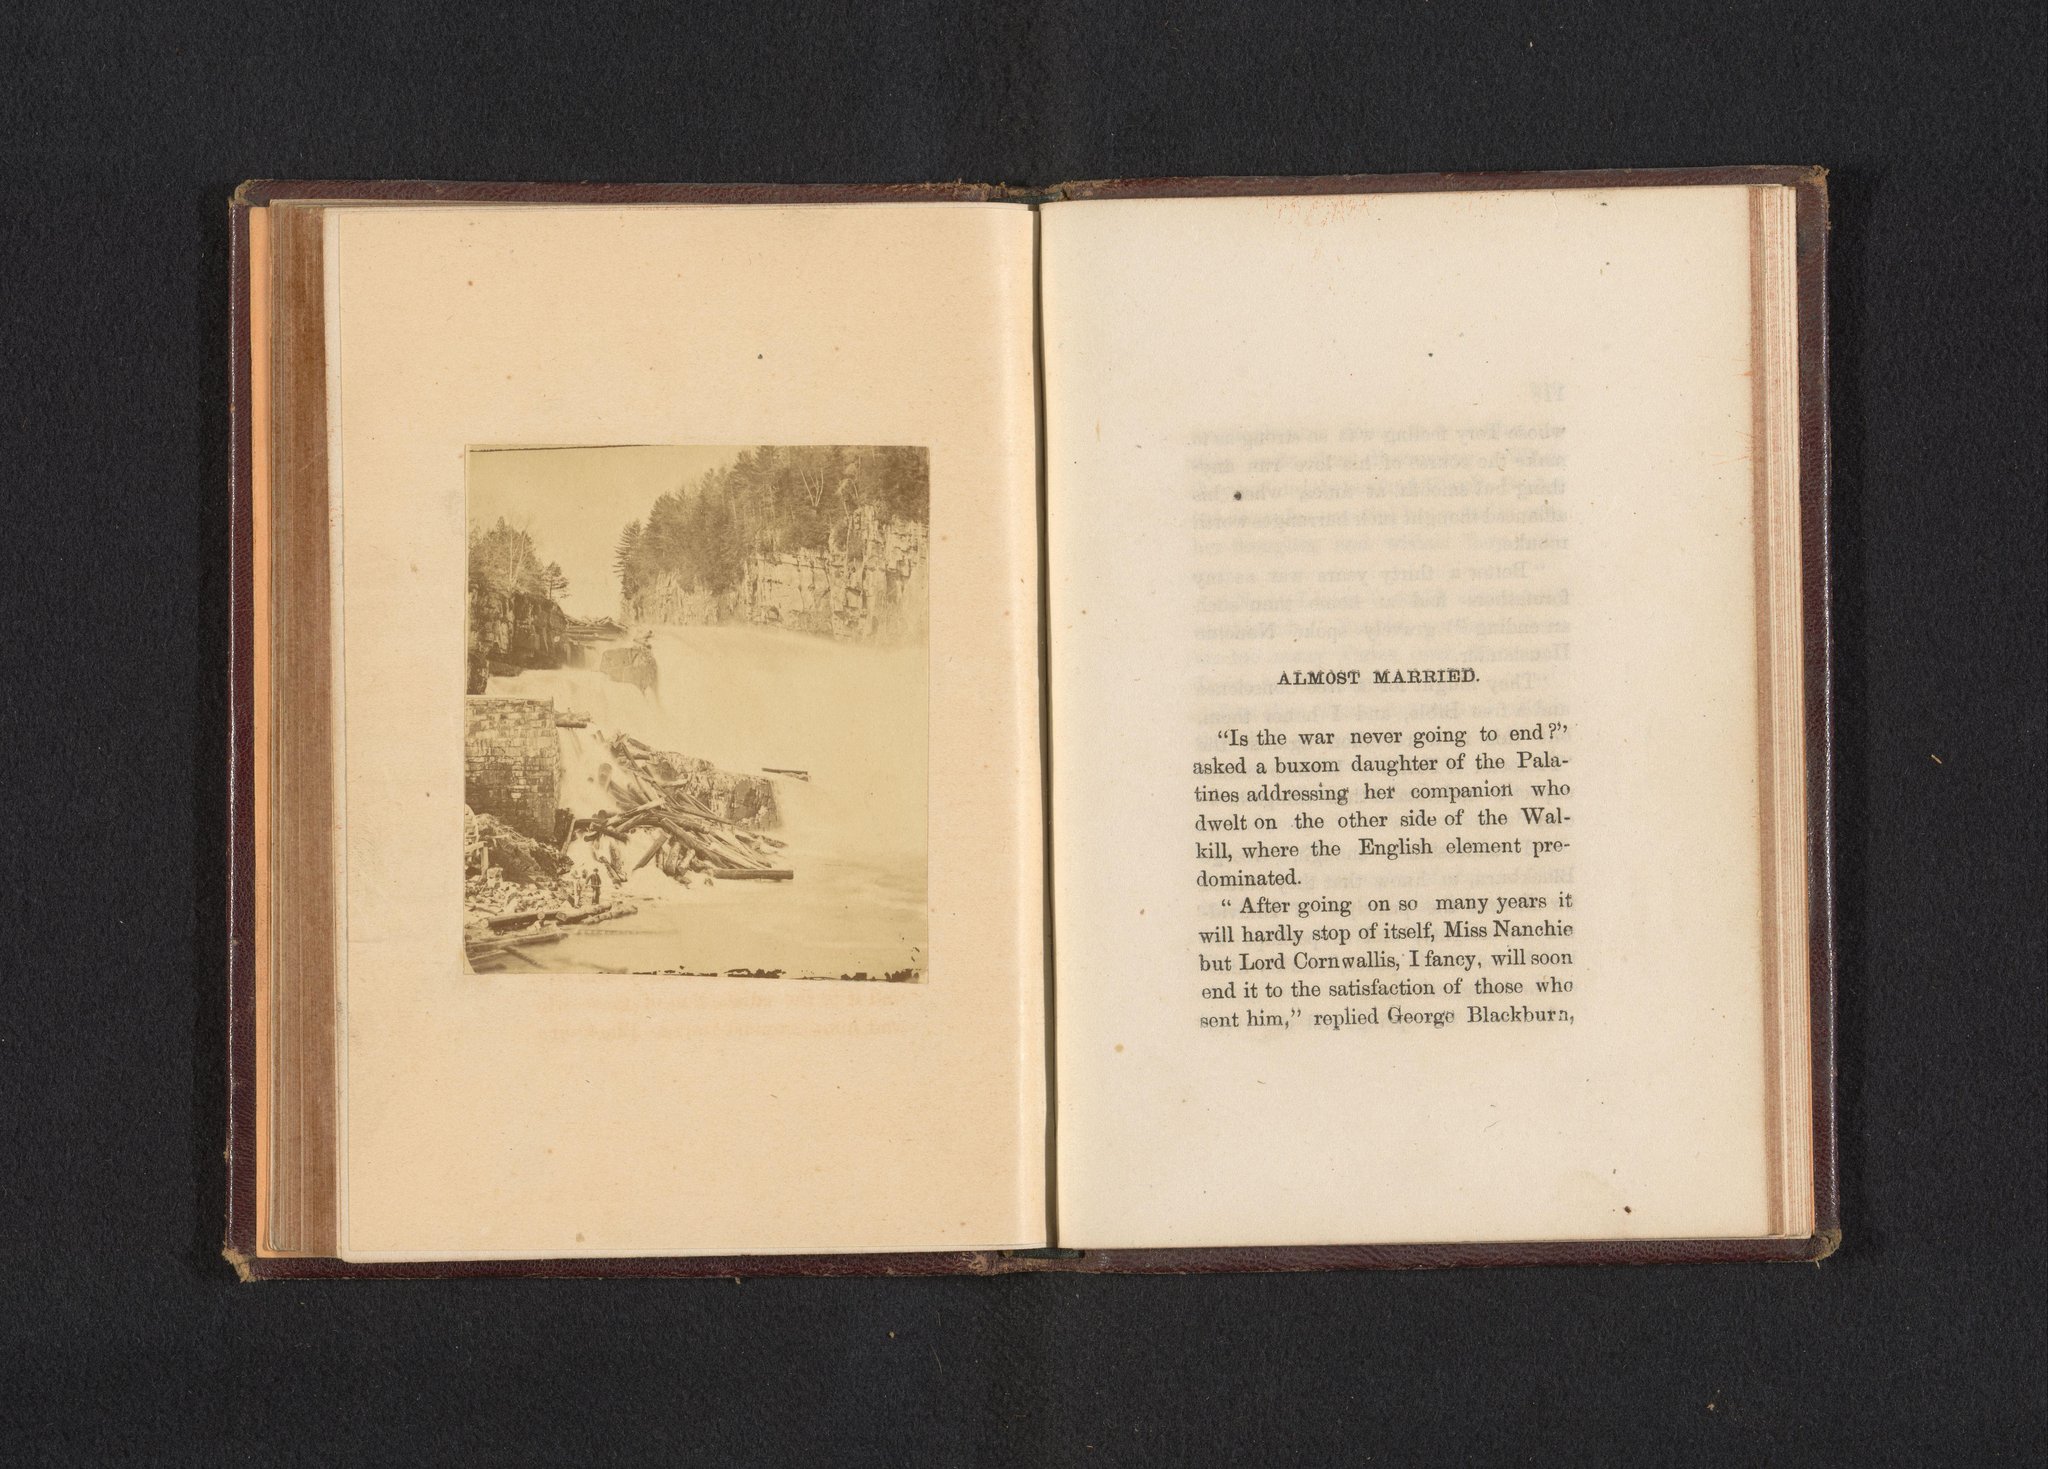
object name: page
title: Gezicht op een waterval (vermoedelijk) in de Hudson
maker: Anonymous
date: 1863-1868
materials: photographic support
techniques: albumen print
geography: new york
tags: waterfall